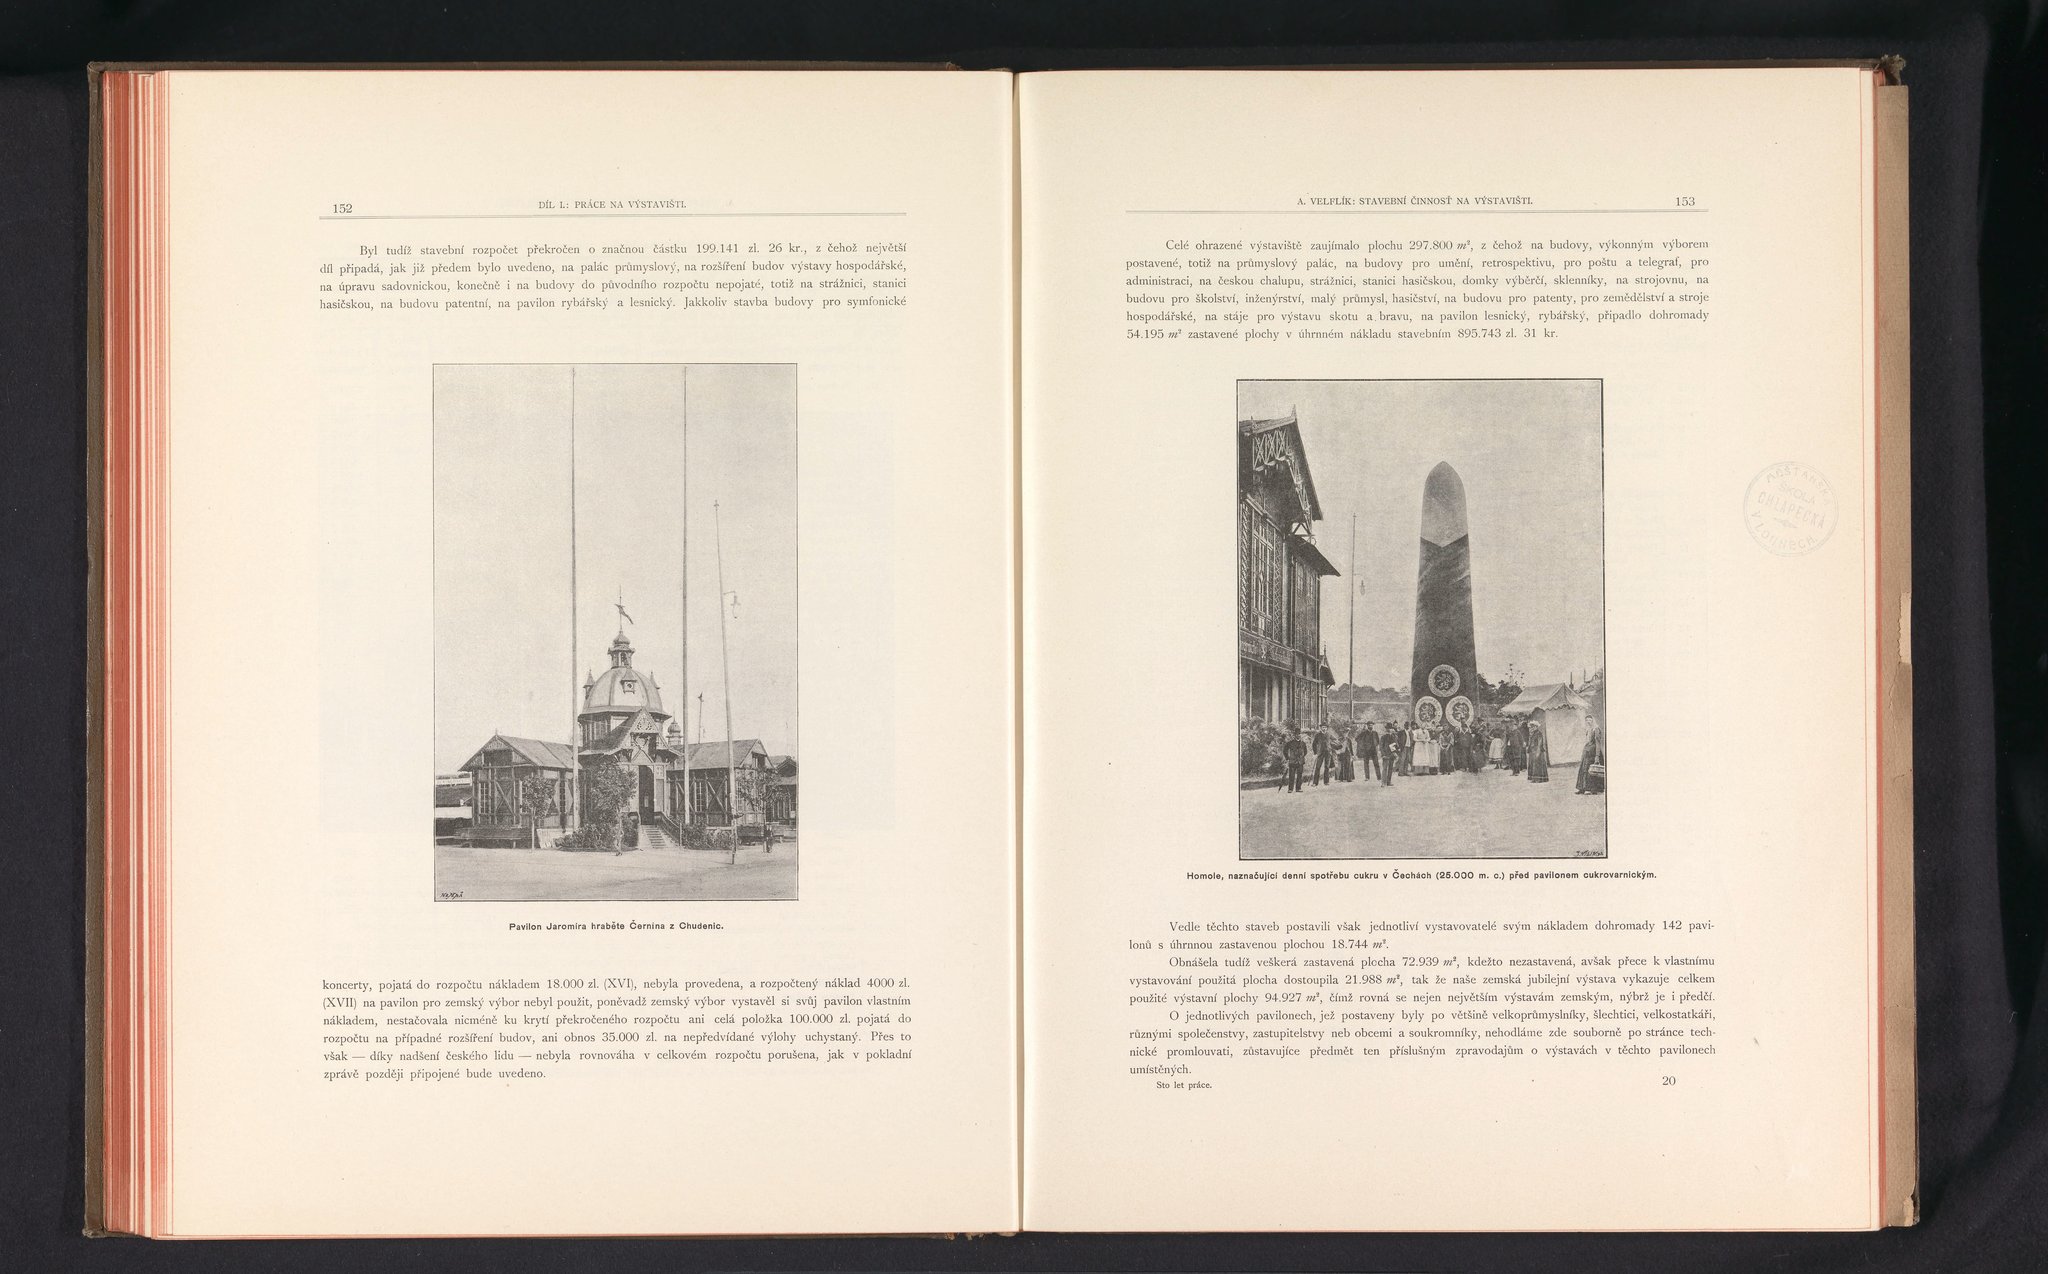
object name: page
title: Homole, naznacujici denní spotrebu cukru v Cechách (25.000 m.c.) pred pavilonem cukrovarnickým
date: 1888-1893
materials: paper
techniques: autotype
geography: prague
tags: landscape with monument, façade (of house or building), temporary exhibition, 'salon'